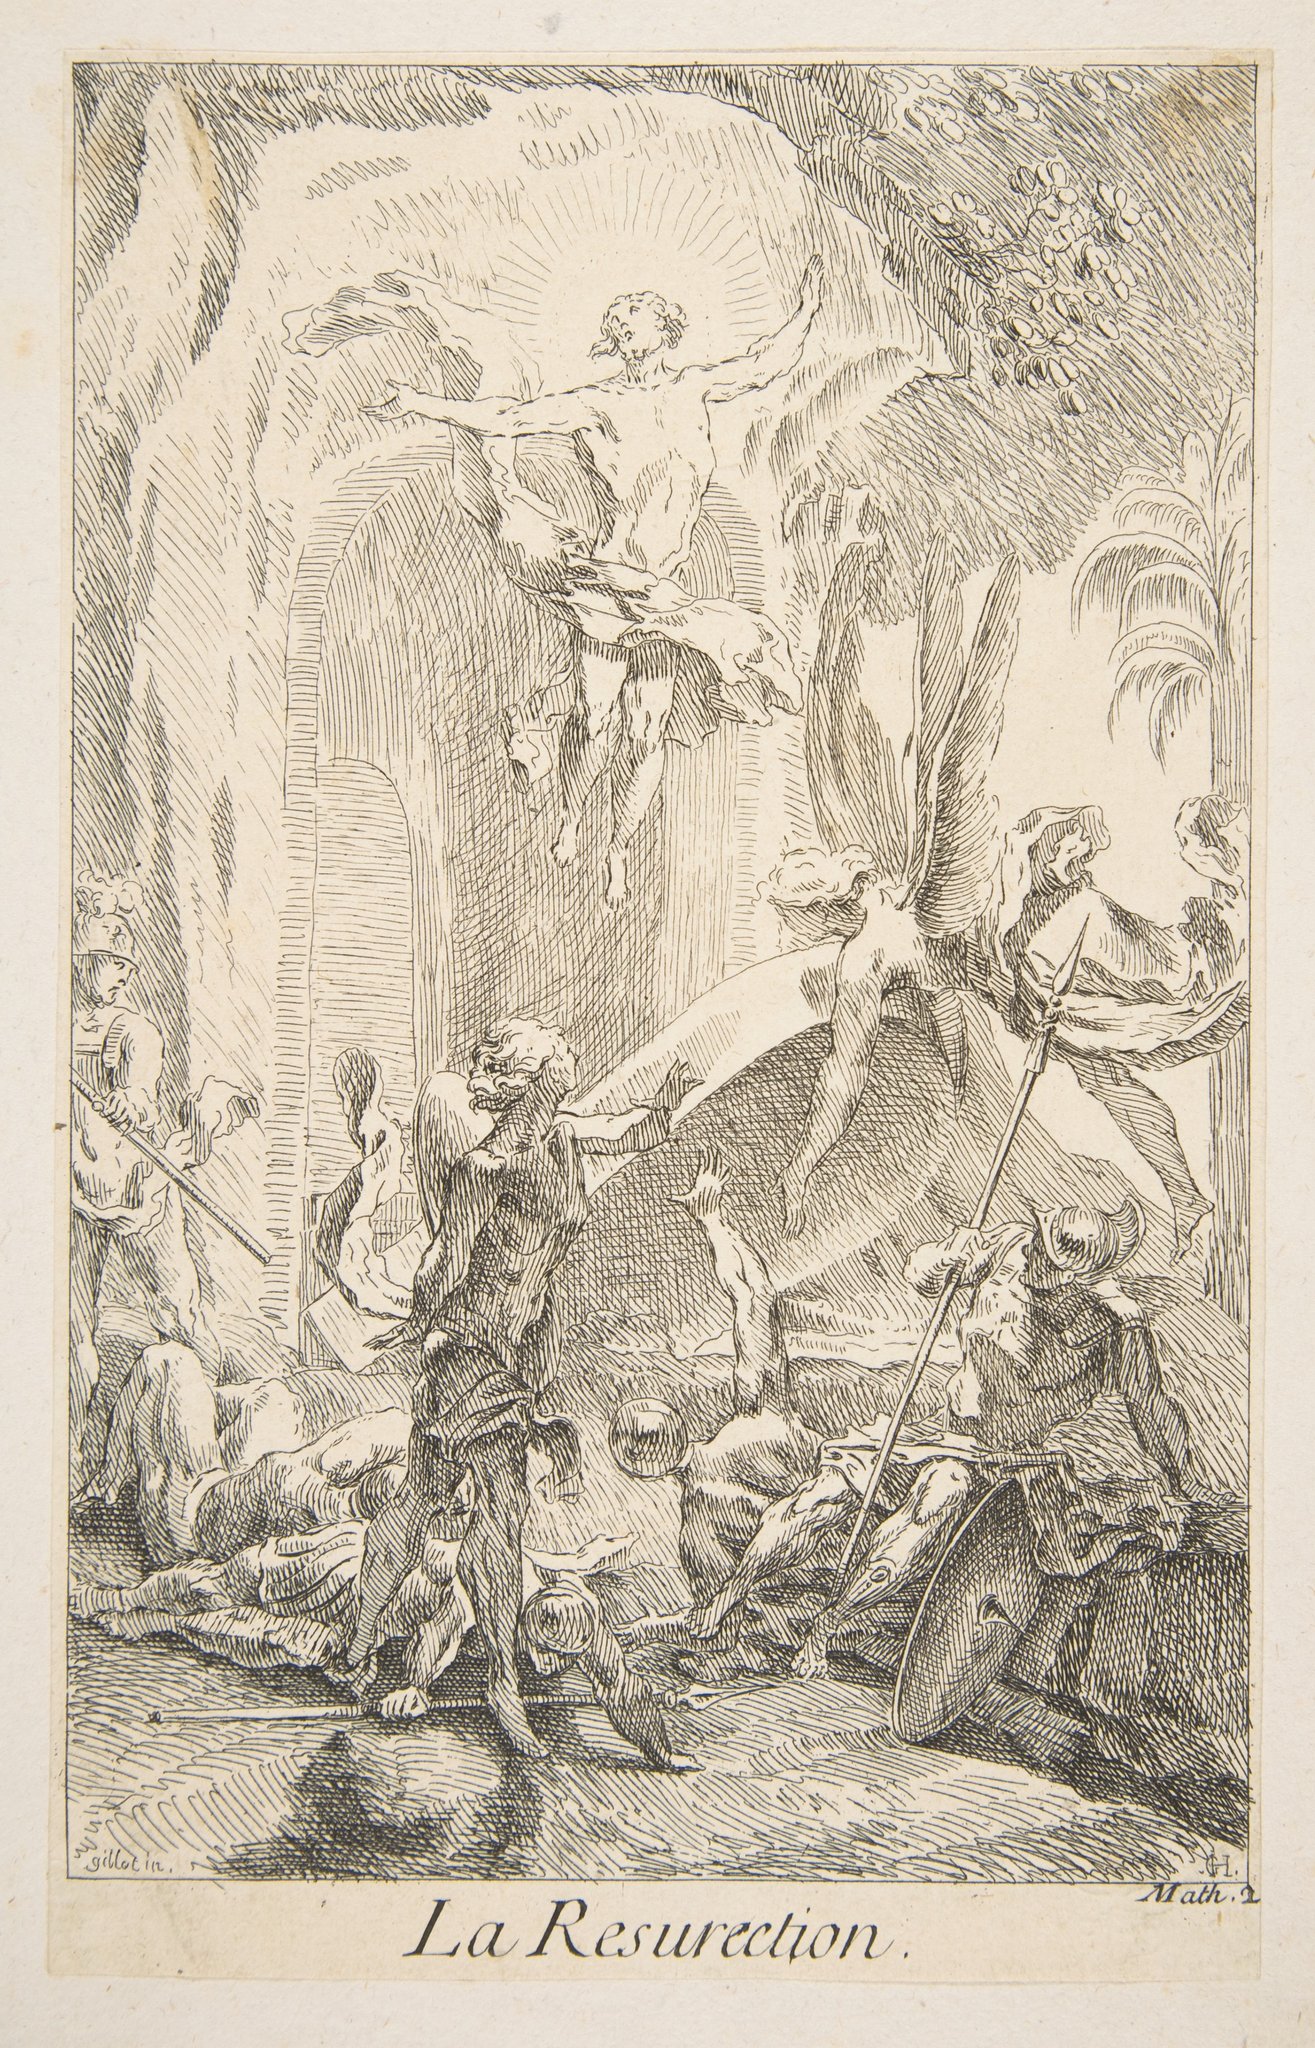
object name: print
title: Resurrection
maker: claude gillot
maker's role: artist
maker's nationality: french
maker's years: 1673-1722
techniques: etching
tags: spears,jesus,death